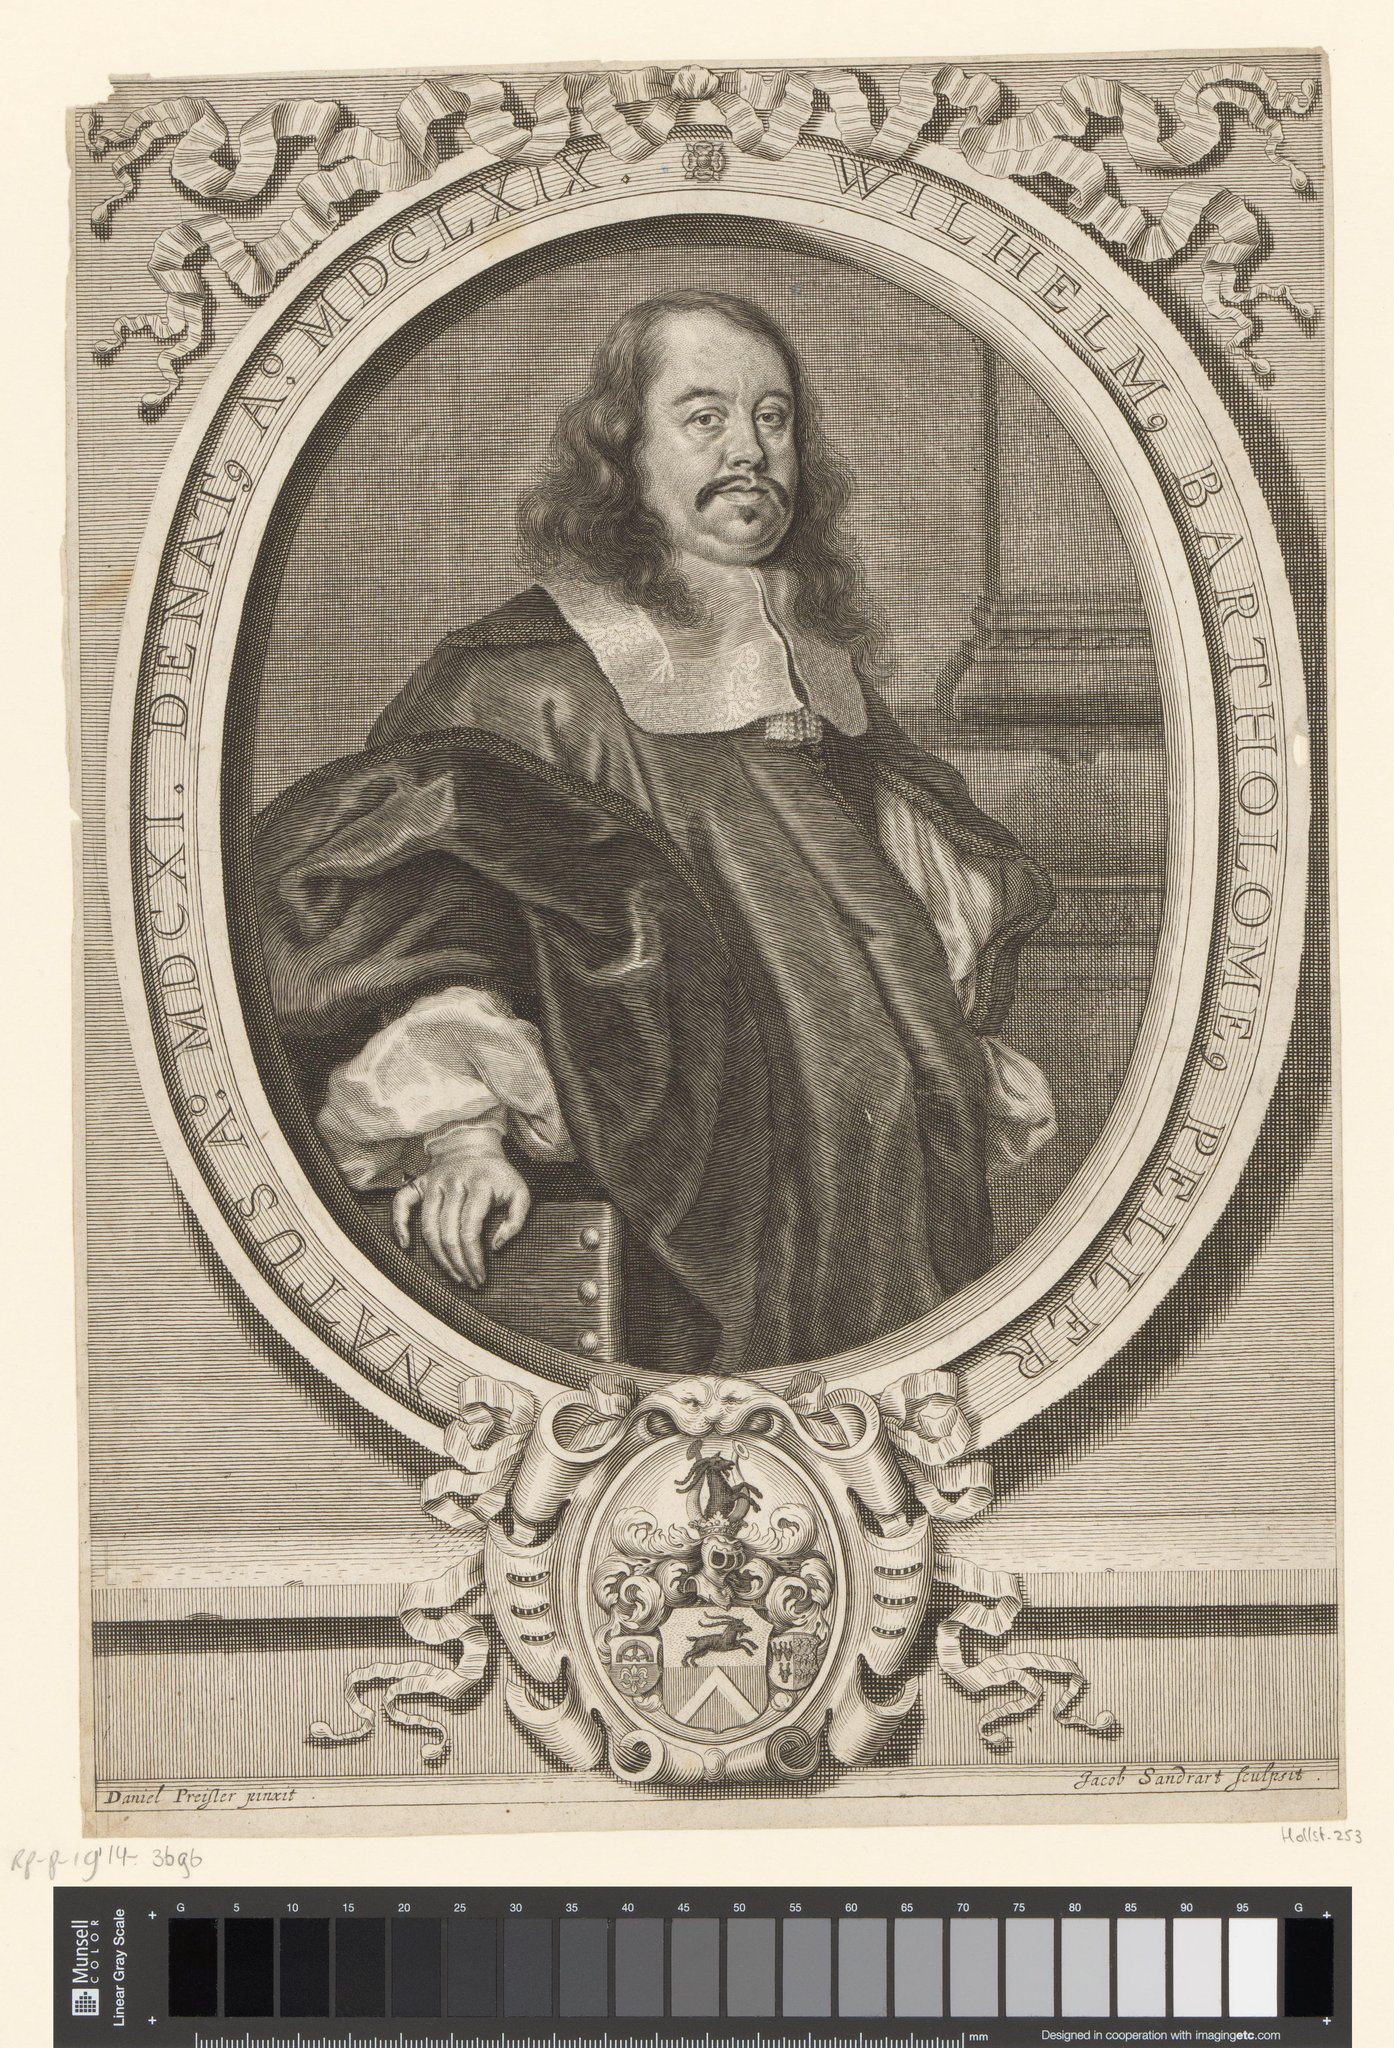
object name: print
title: Portret van Wilhelm Balrtholomäus Peller von Schoppershof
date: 1669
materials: paper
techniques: engraving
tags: historical persons, ring, armorial bearing, heraldry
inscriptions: collector's mark: Lugt 2228